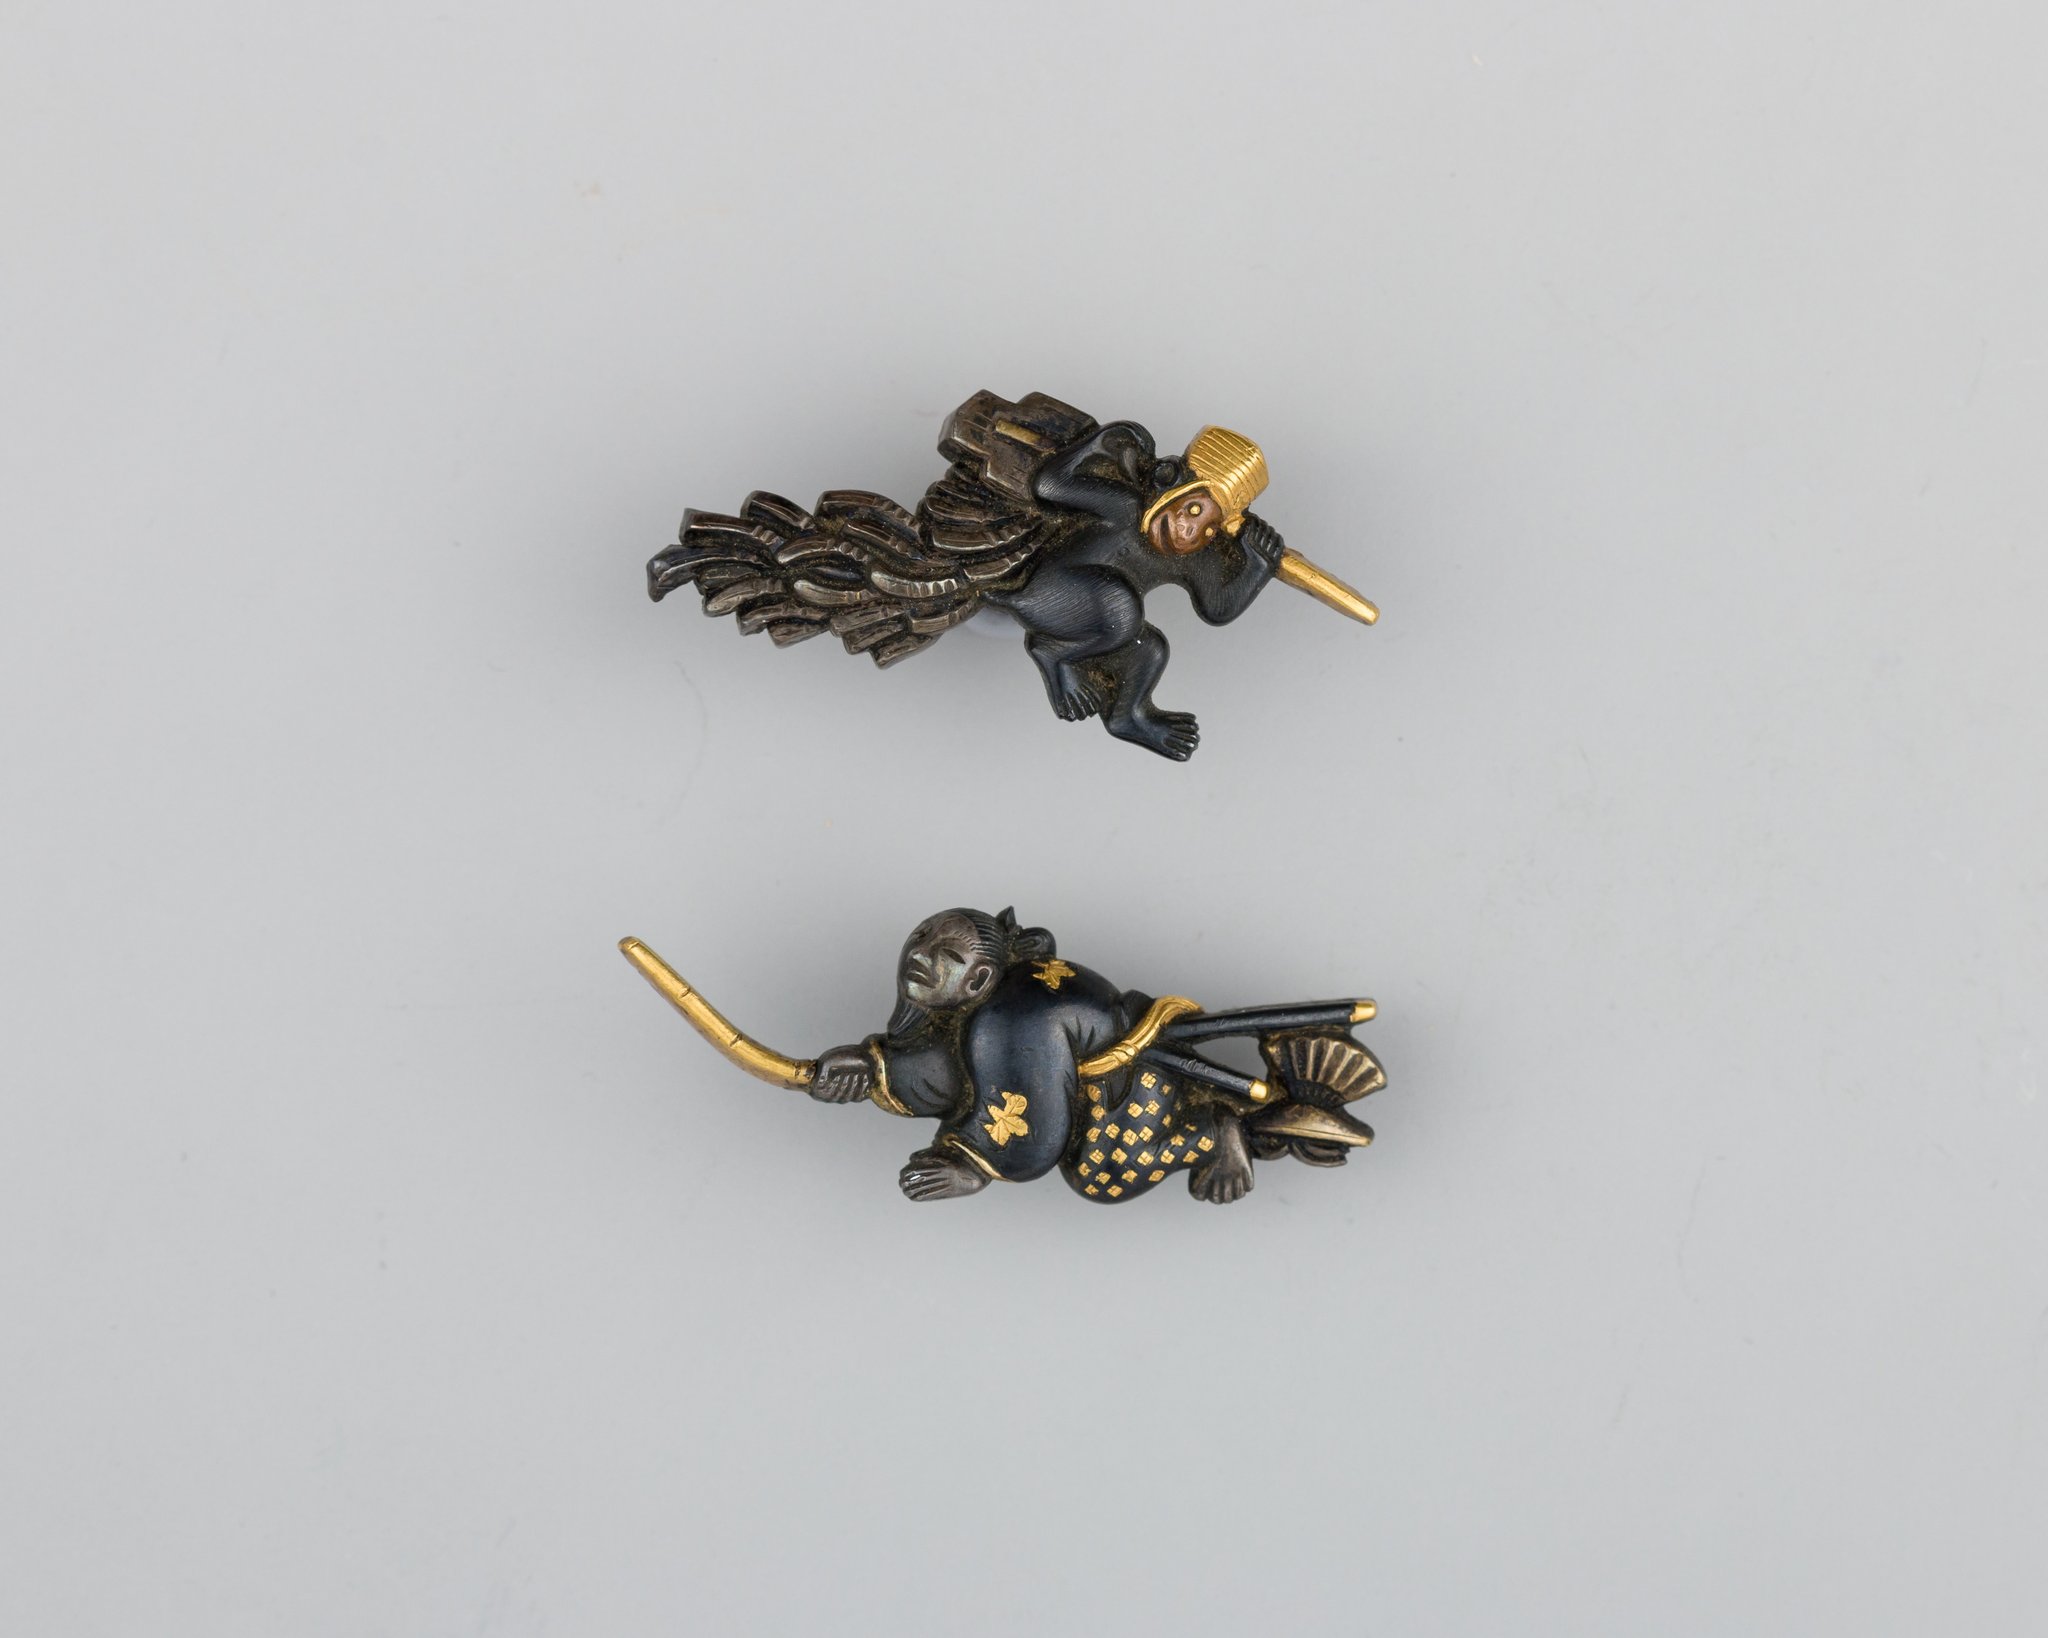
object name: pair of sword grip ornament menuki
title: Pair of Sword-Grip Ornaments (Menuki)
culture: japanese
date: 1801-1900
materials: copper, gold alloy, gold, silver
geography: japan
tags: human figures